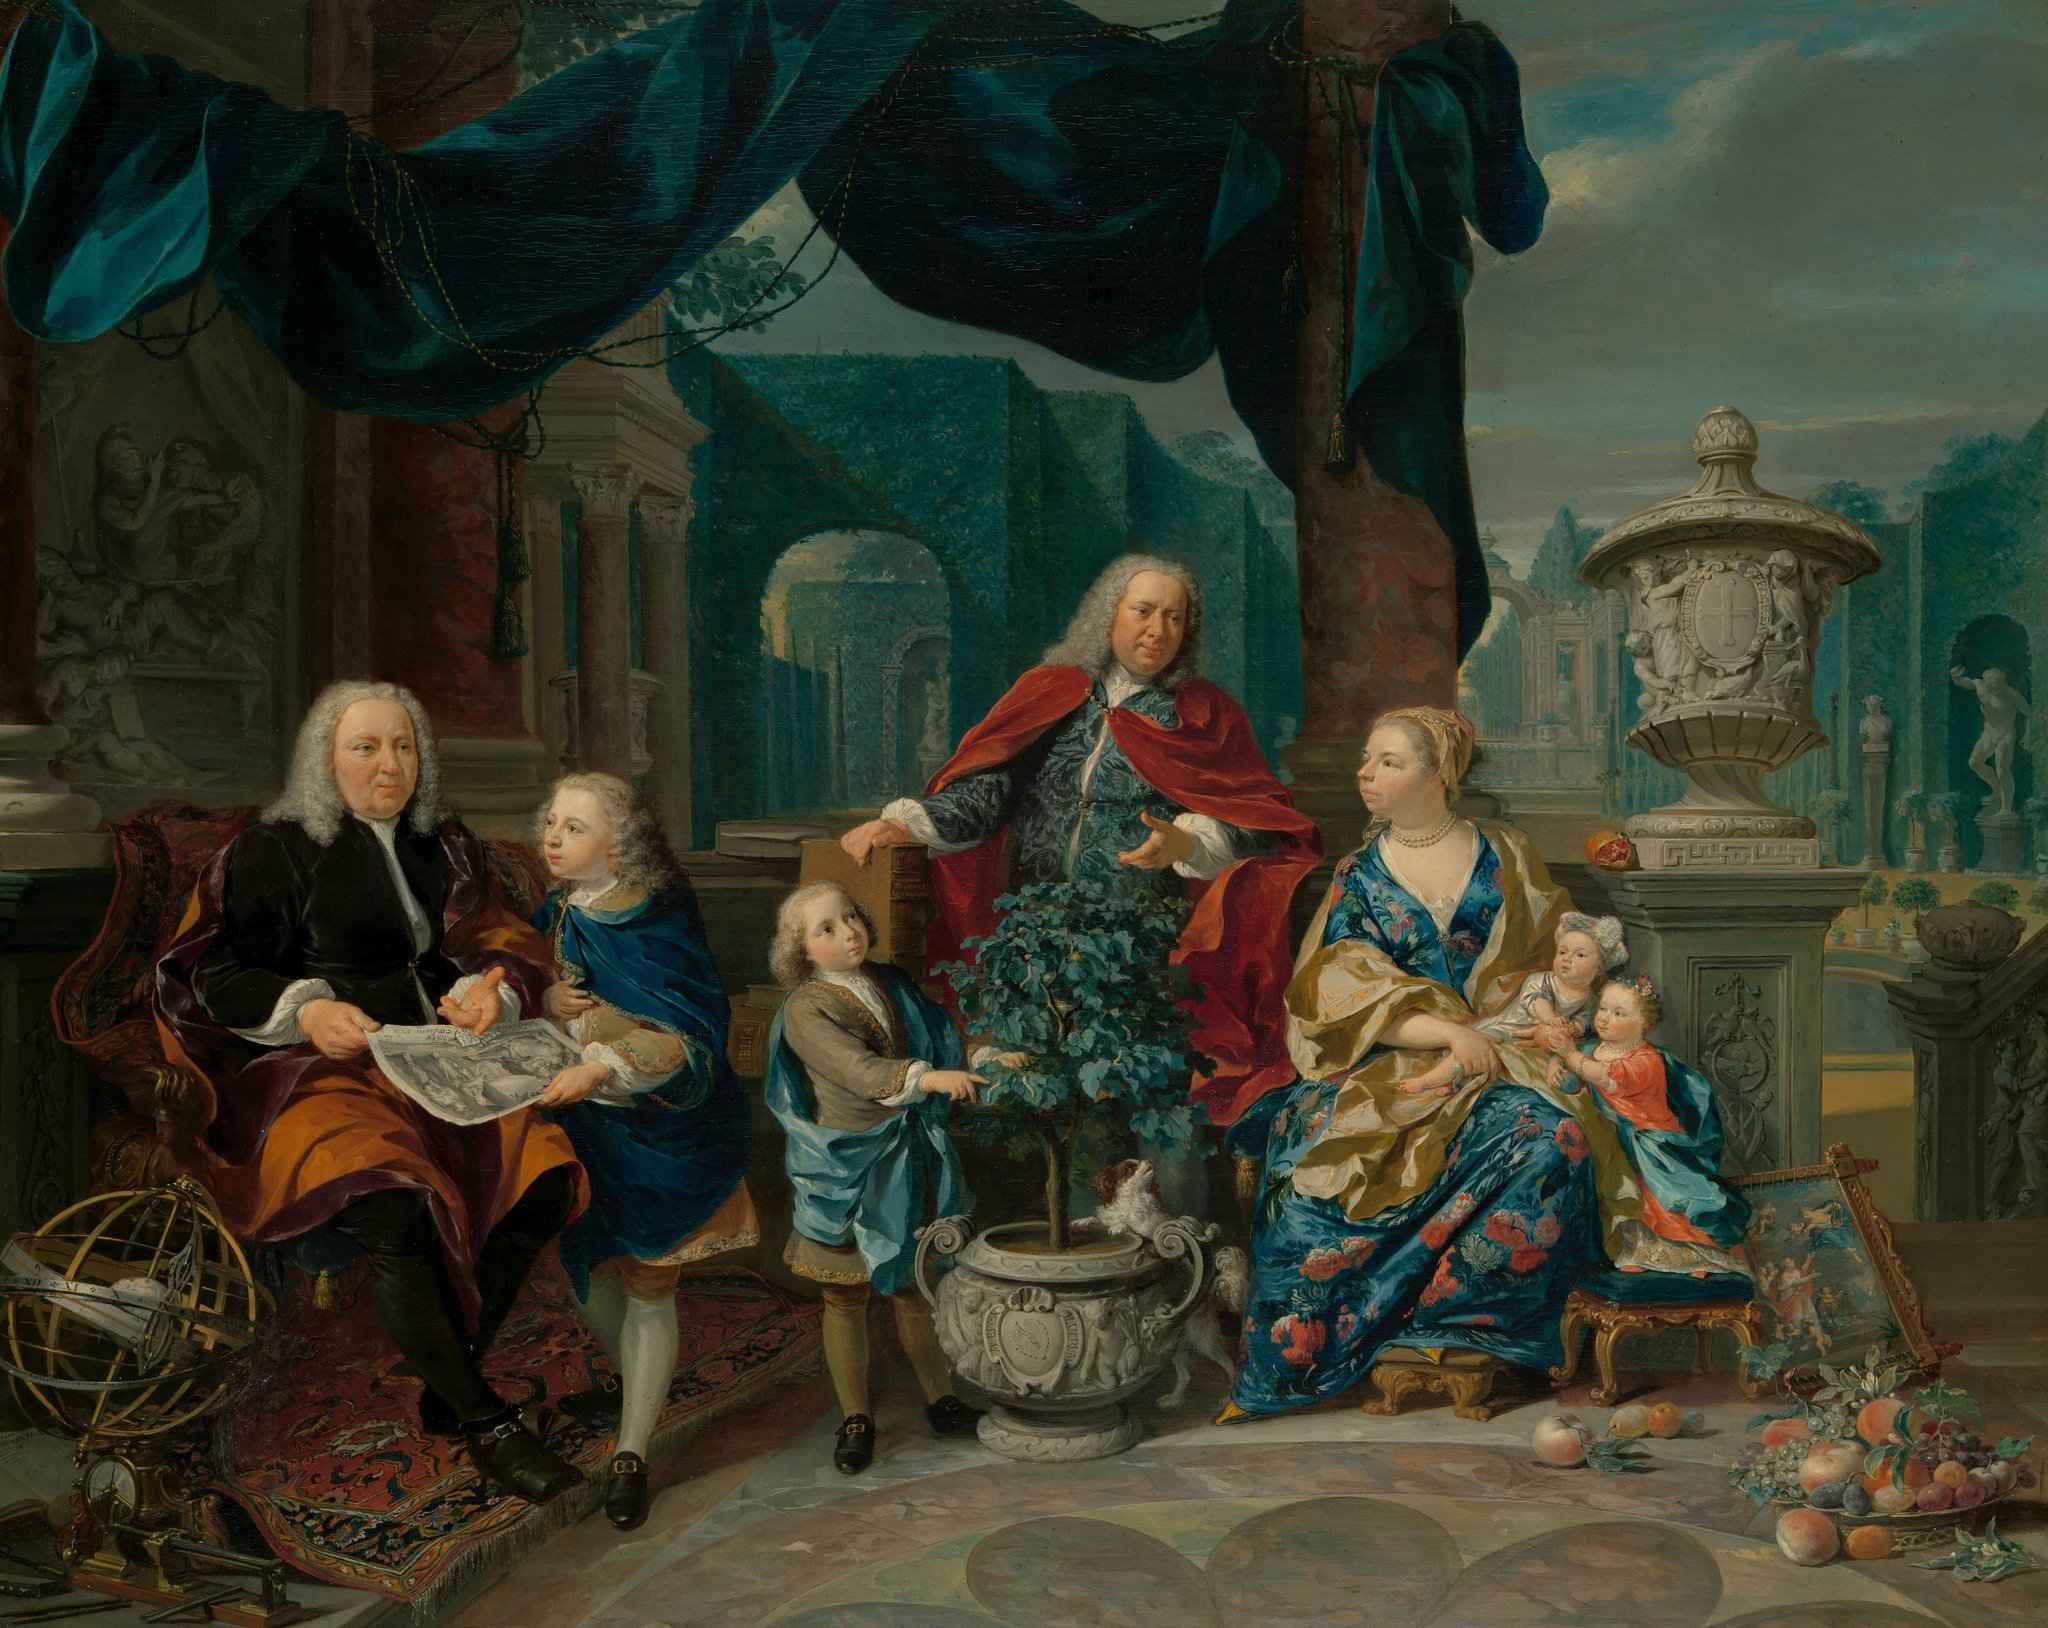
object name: painting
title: Portrait of David van Mollen and Son-in-Law Jacob Sydervelt with his Family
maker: nicolaas verkolje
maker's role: draughtsman, painter, print maker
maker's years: 1673-1746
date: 1740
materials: oil, panel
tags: print, e.g.: engraving, etching, lithograph, family group, especially parents with their child(ren), armillary sphere, skeleton celestial globe, garden vase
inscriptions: signature and date: ‘Nic. Verkolje 1740’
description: David van Mollem (left) is seated in the garden of his country house Zijdebalen on the River Vecht. He was portrayed by Nicolaas Verkolje, who also designed his garden. Van Mollem was a silk merchant and a major shareholder of the Utrechtsche Compagnie. This Company bought the Suriname Utrecht coffee plantation in 1736 and thus became the ‘owner’ of 37 men, 20 women and 2 children, who were forced to work on the plantation unpaid.